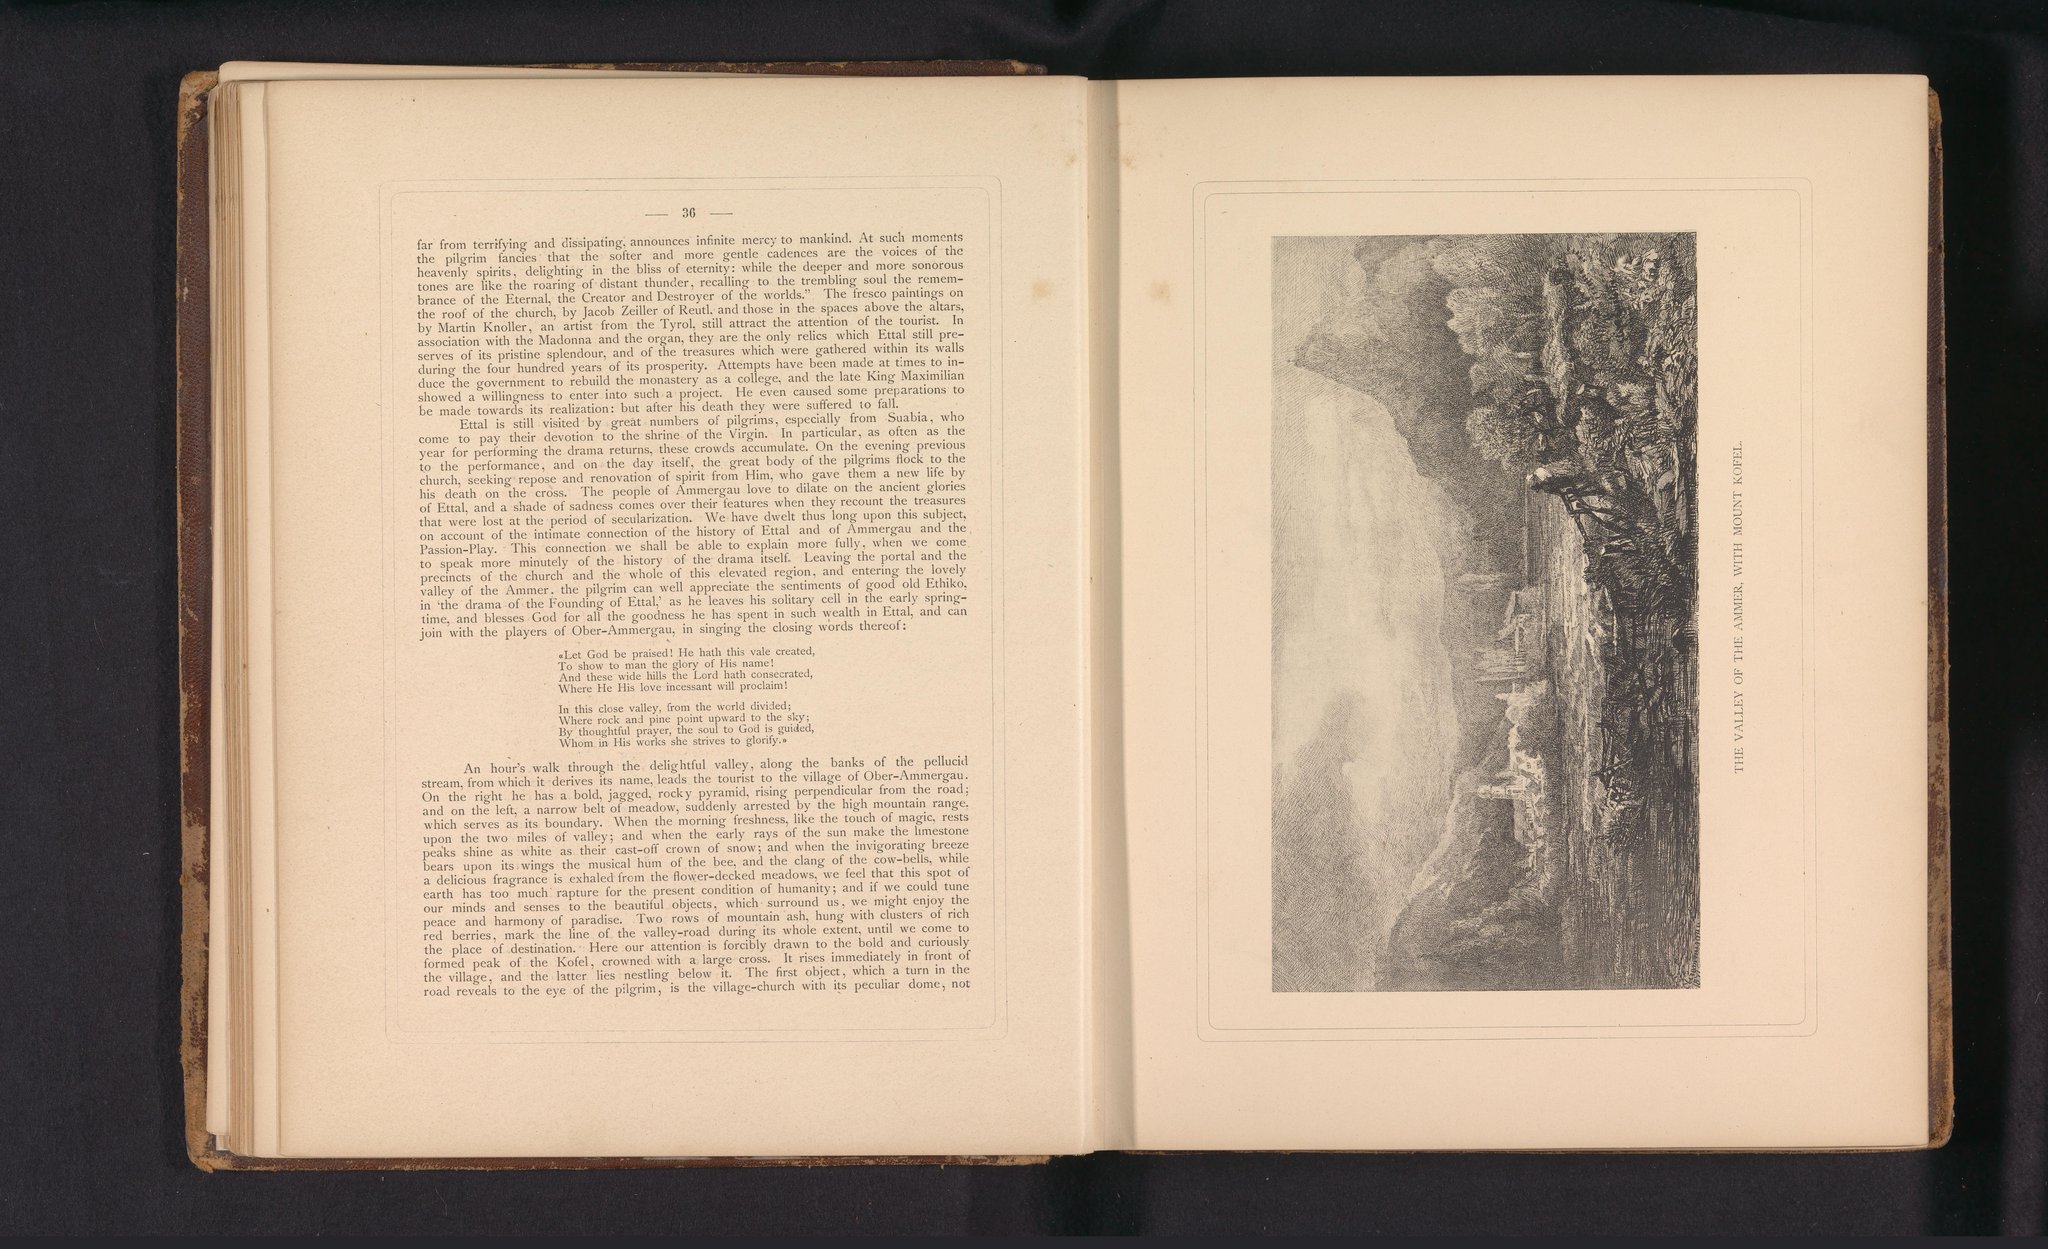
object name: page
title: The valley of the Ammer, with Mount Kofel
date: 1868-1873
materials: paper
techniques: photograph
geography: oberammergau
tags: dale, valley, river